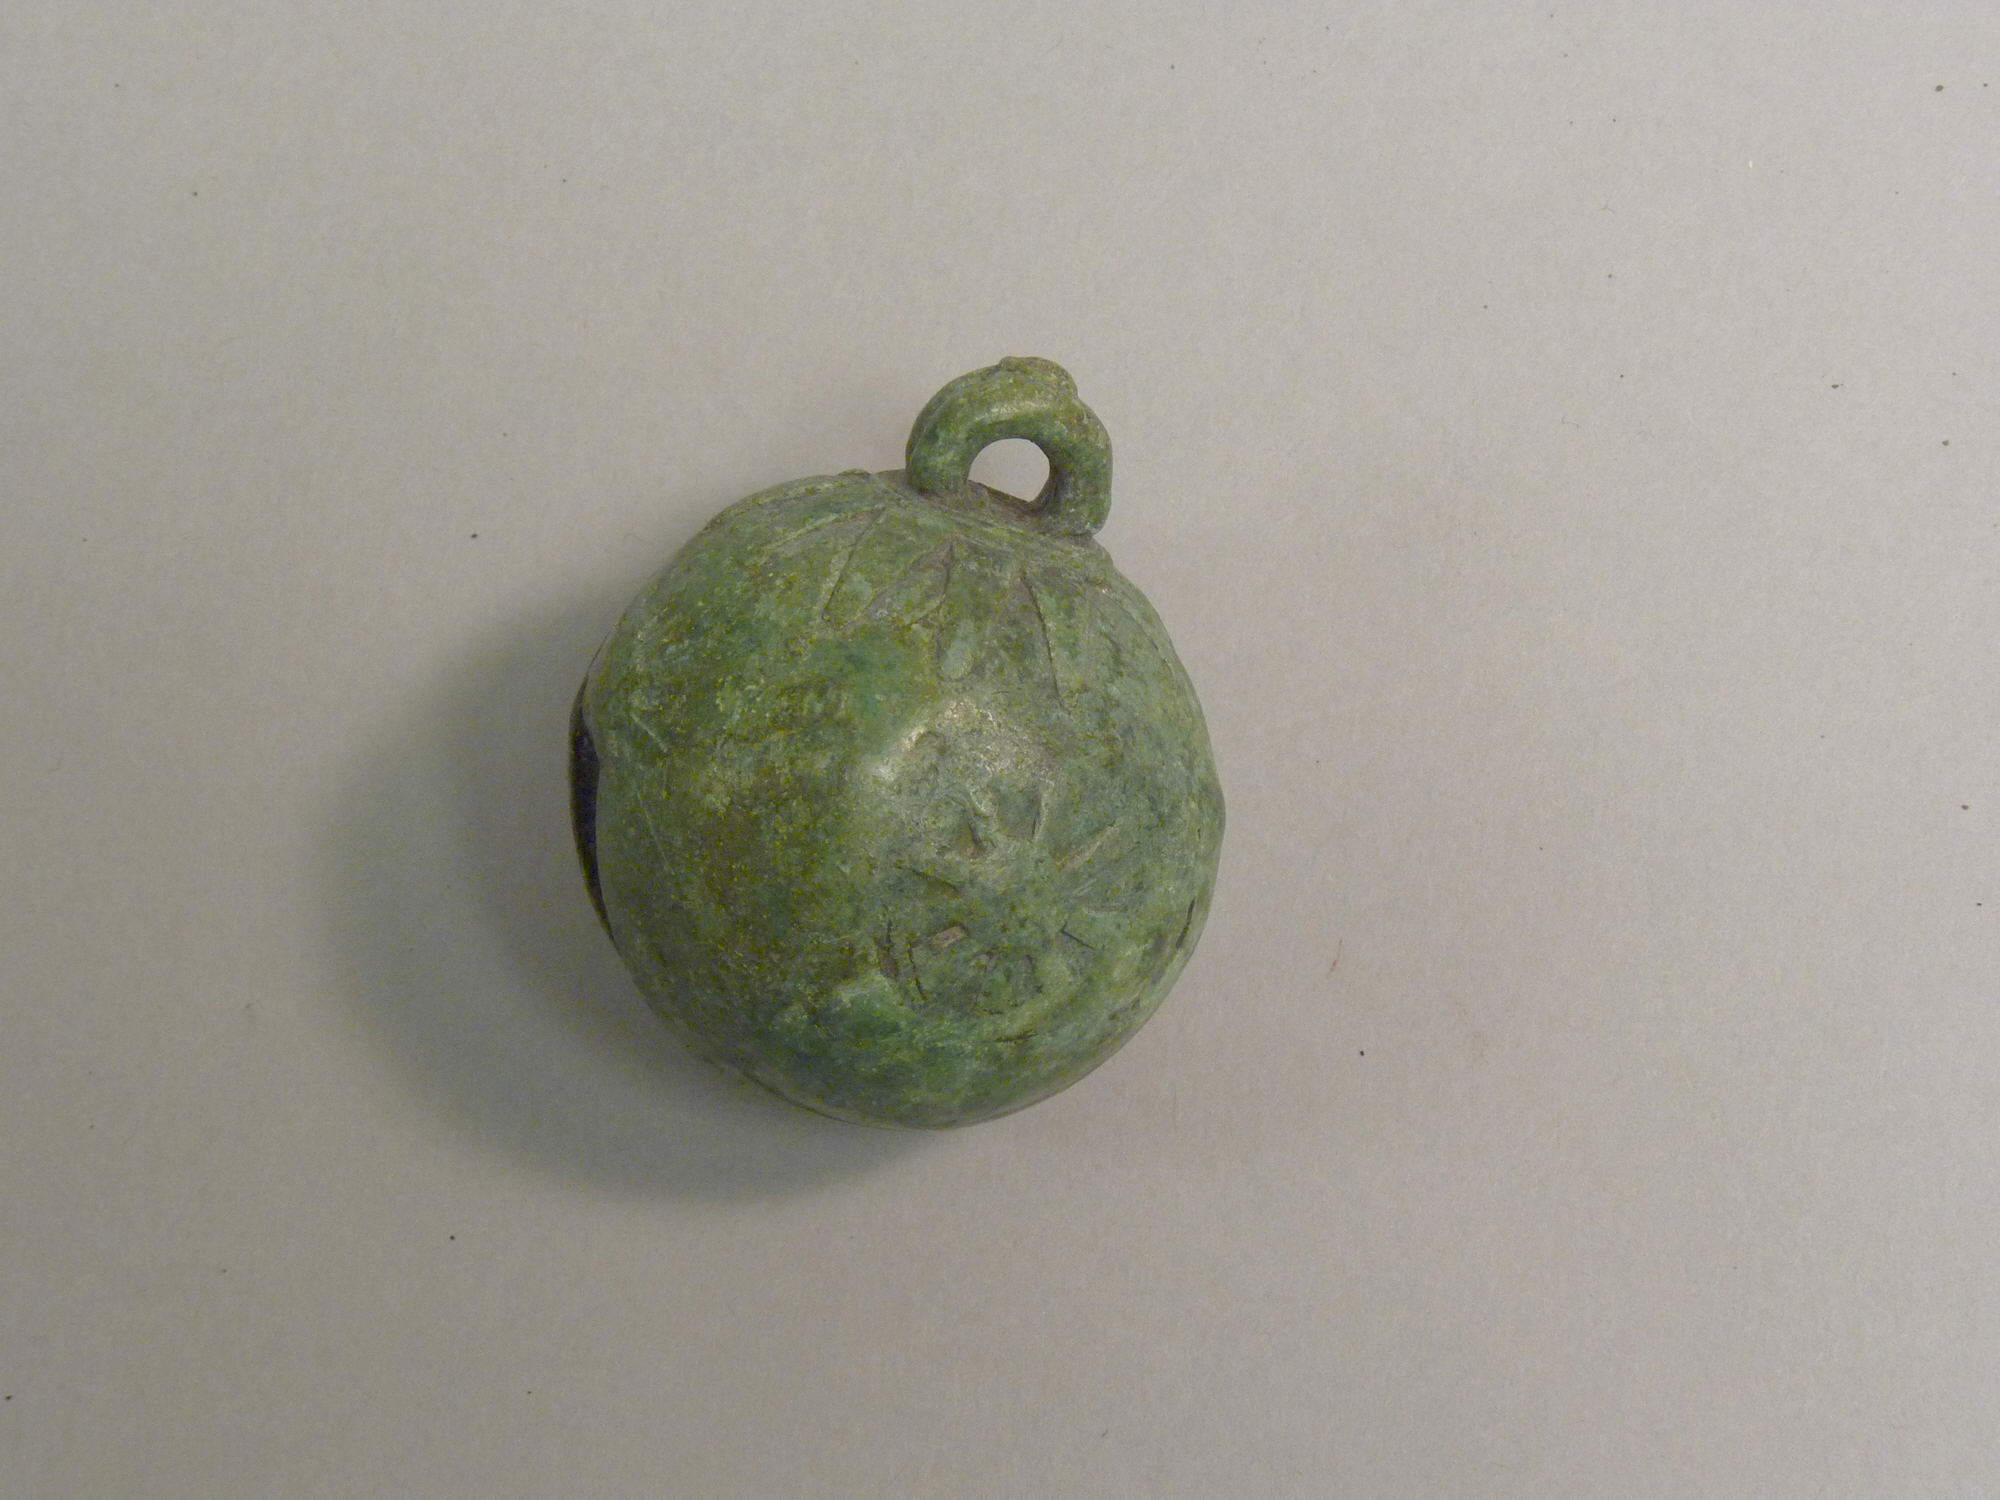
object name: spit ball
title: Spit Ball with Sunburst Motif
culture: indonesian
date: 500 BCE-300 CE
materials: bronze